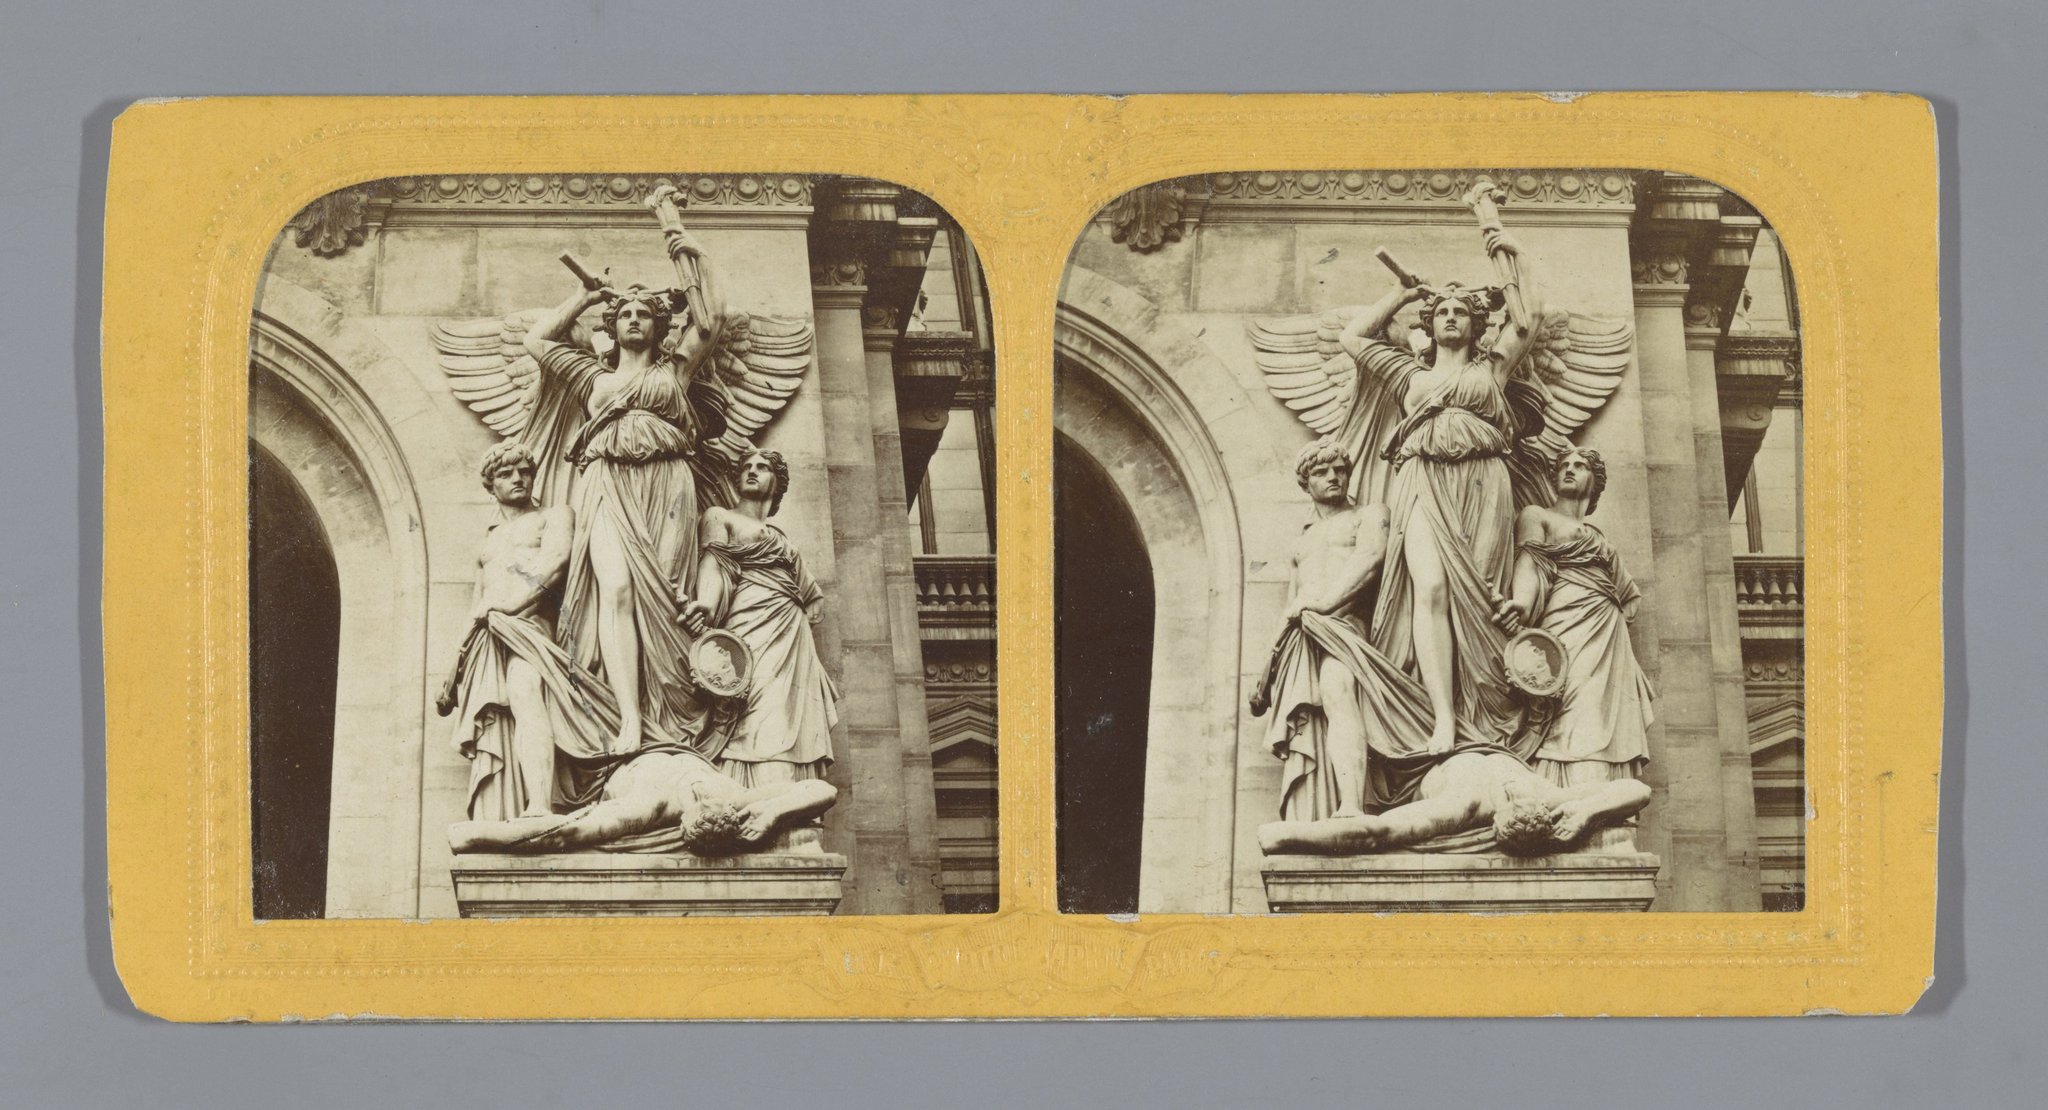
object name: tissue stereograph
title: Beeldengroep op de Opéra Garnier, Parijs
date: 1875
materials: cardboard, paper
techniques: albumen print, cutting, hand coloring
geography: paris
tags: sculpture, opera house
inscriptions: inscription: ‘Déposé’